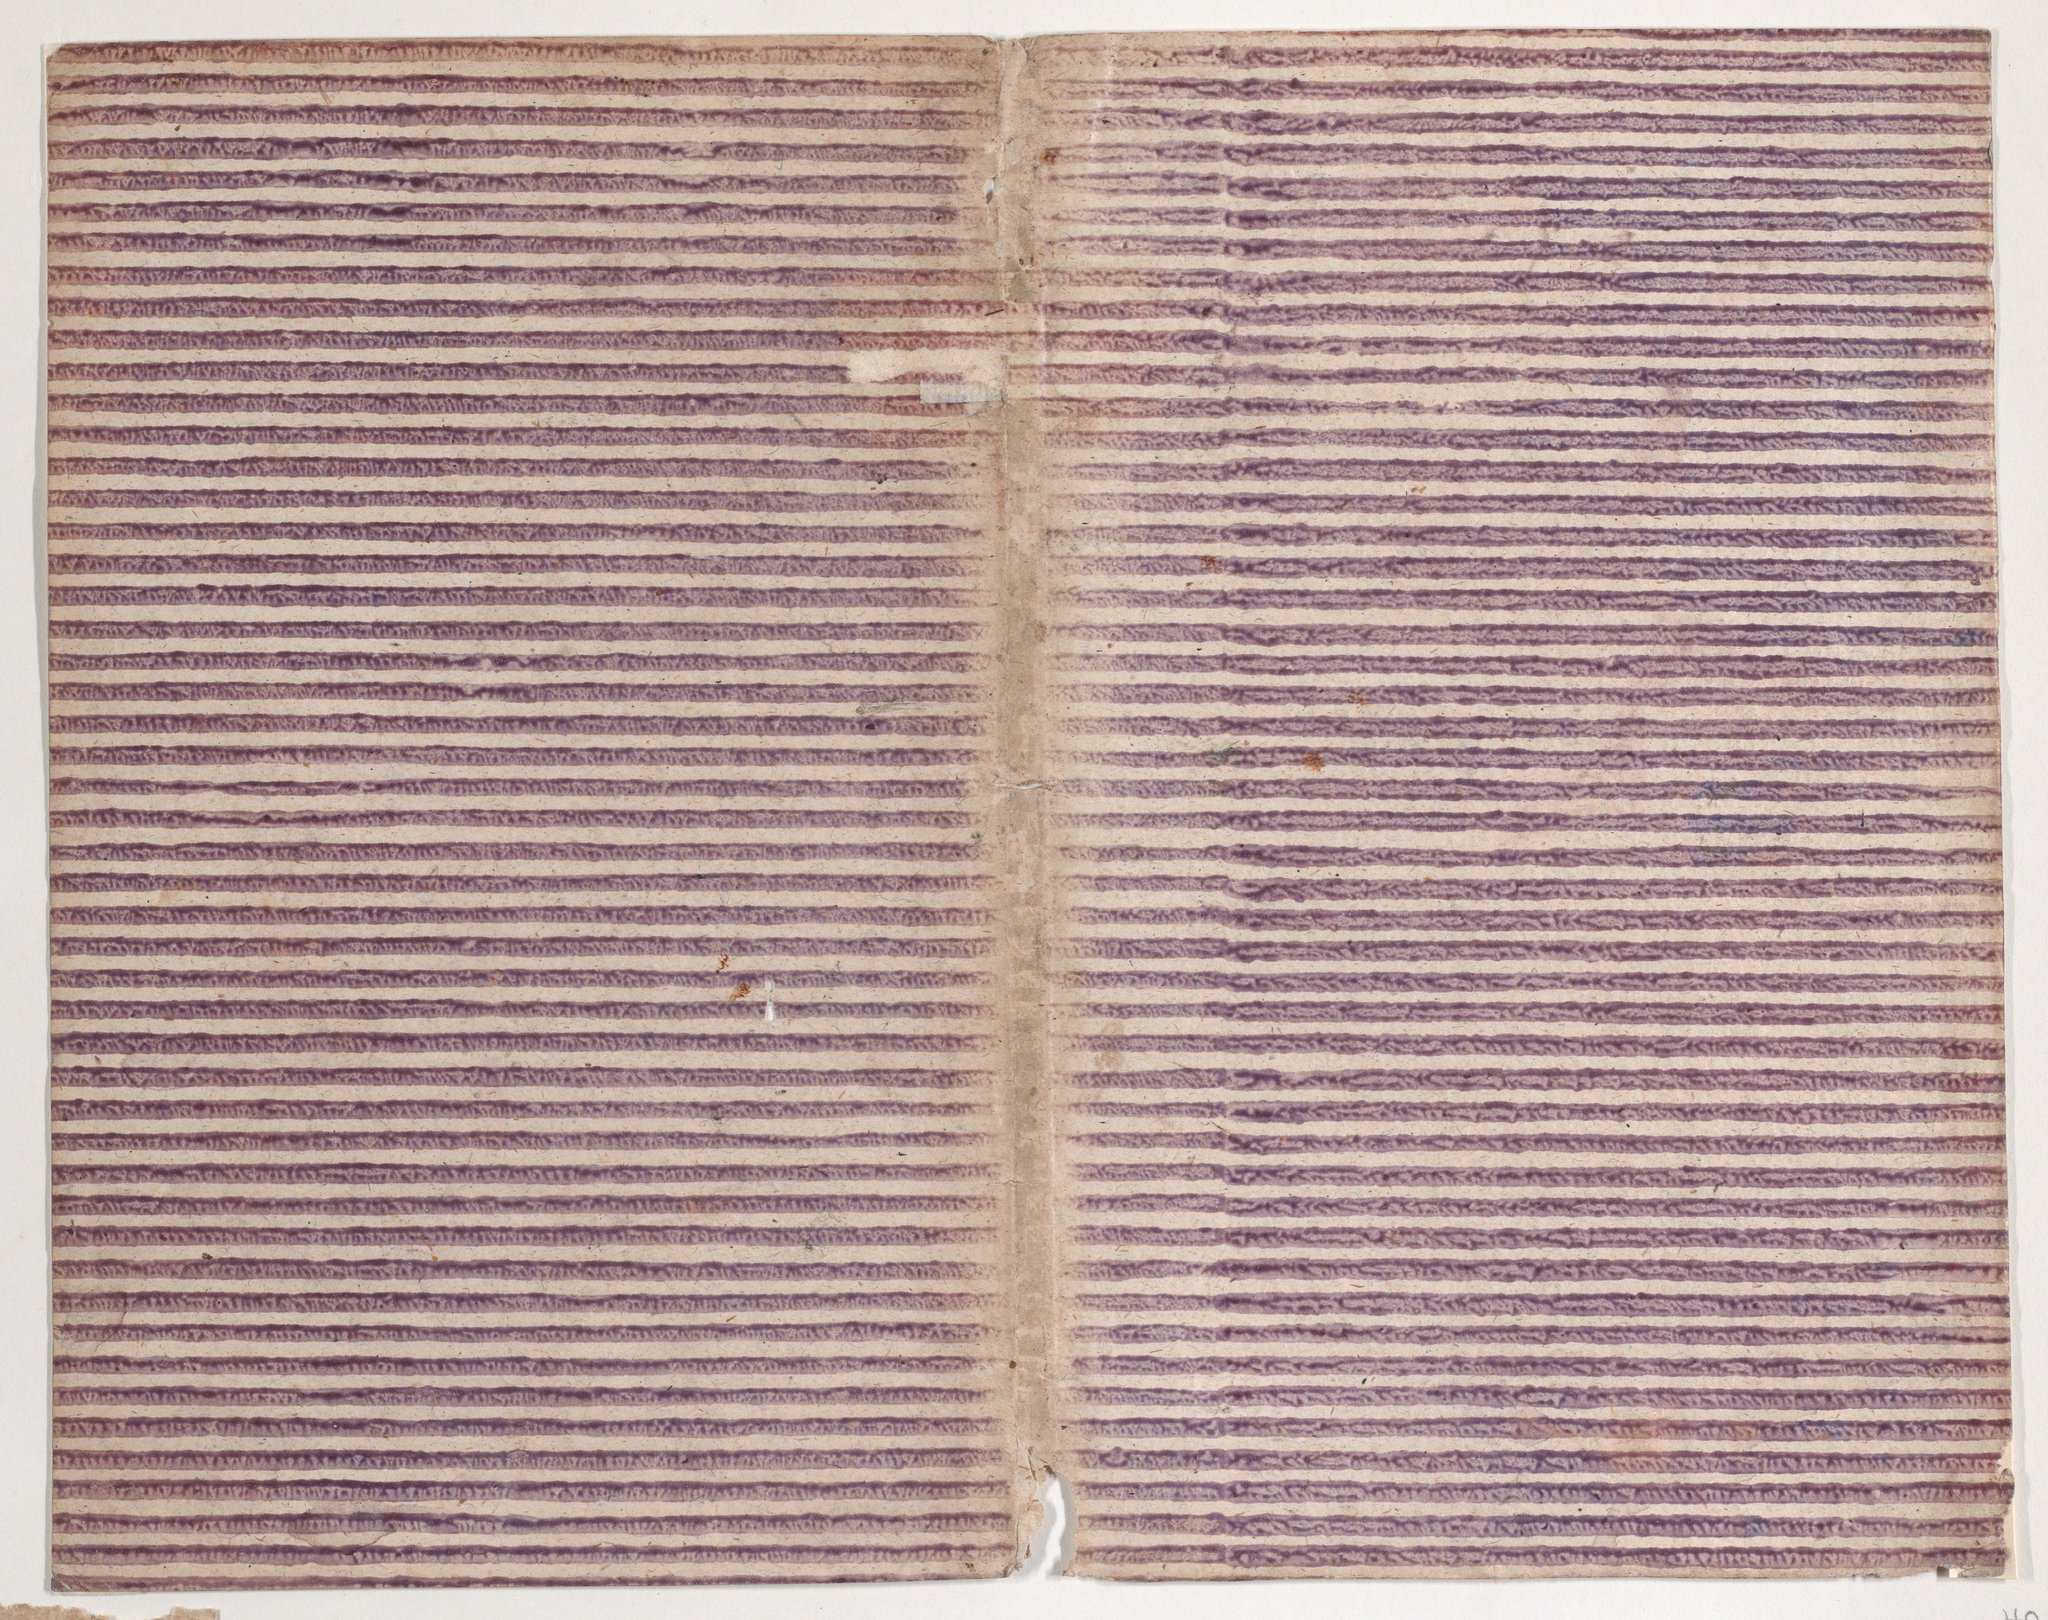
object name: print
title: Book cover with overall purple stripe pattern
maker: Anonymous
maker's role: artist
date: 1801-1900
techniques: relief print